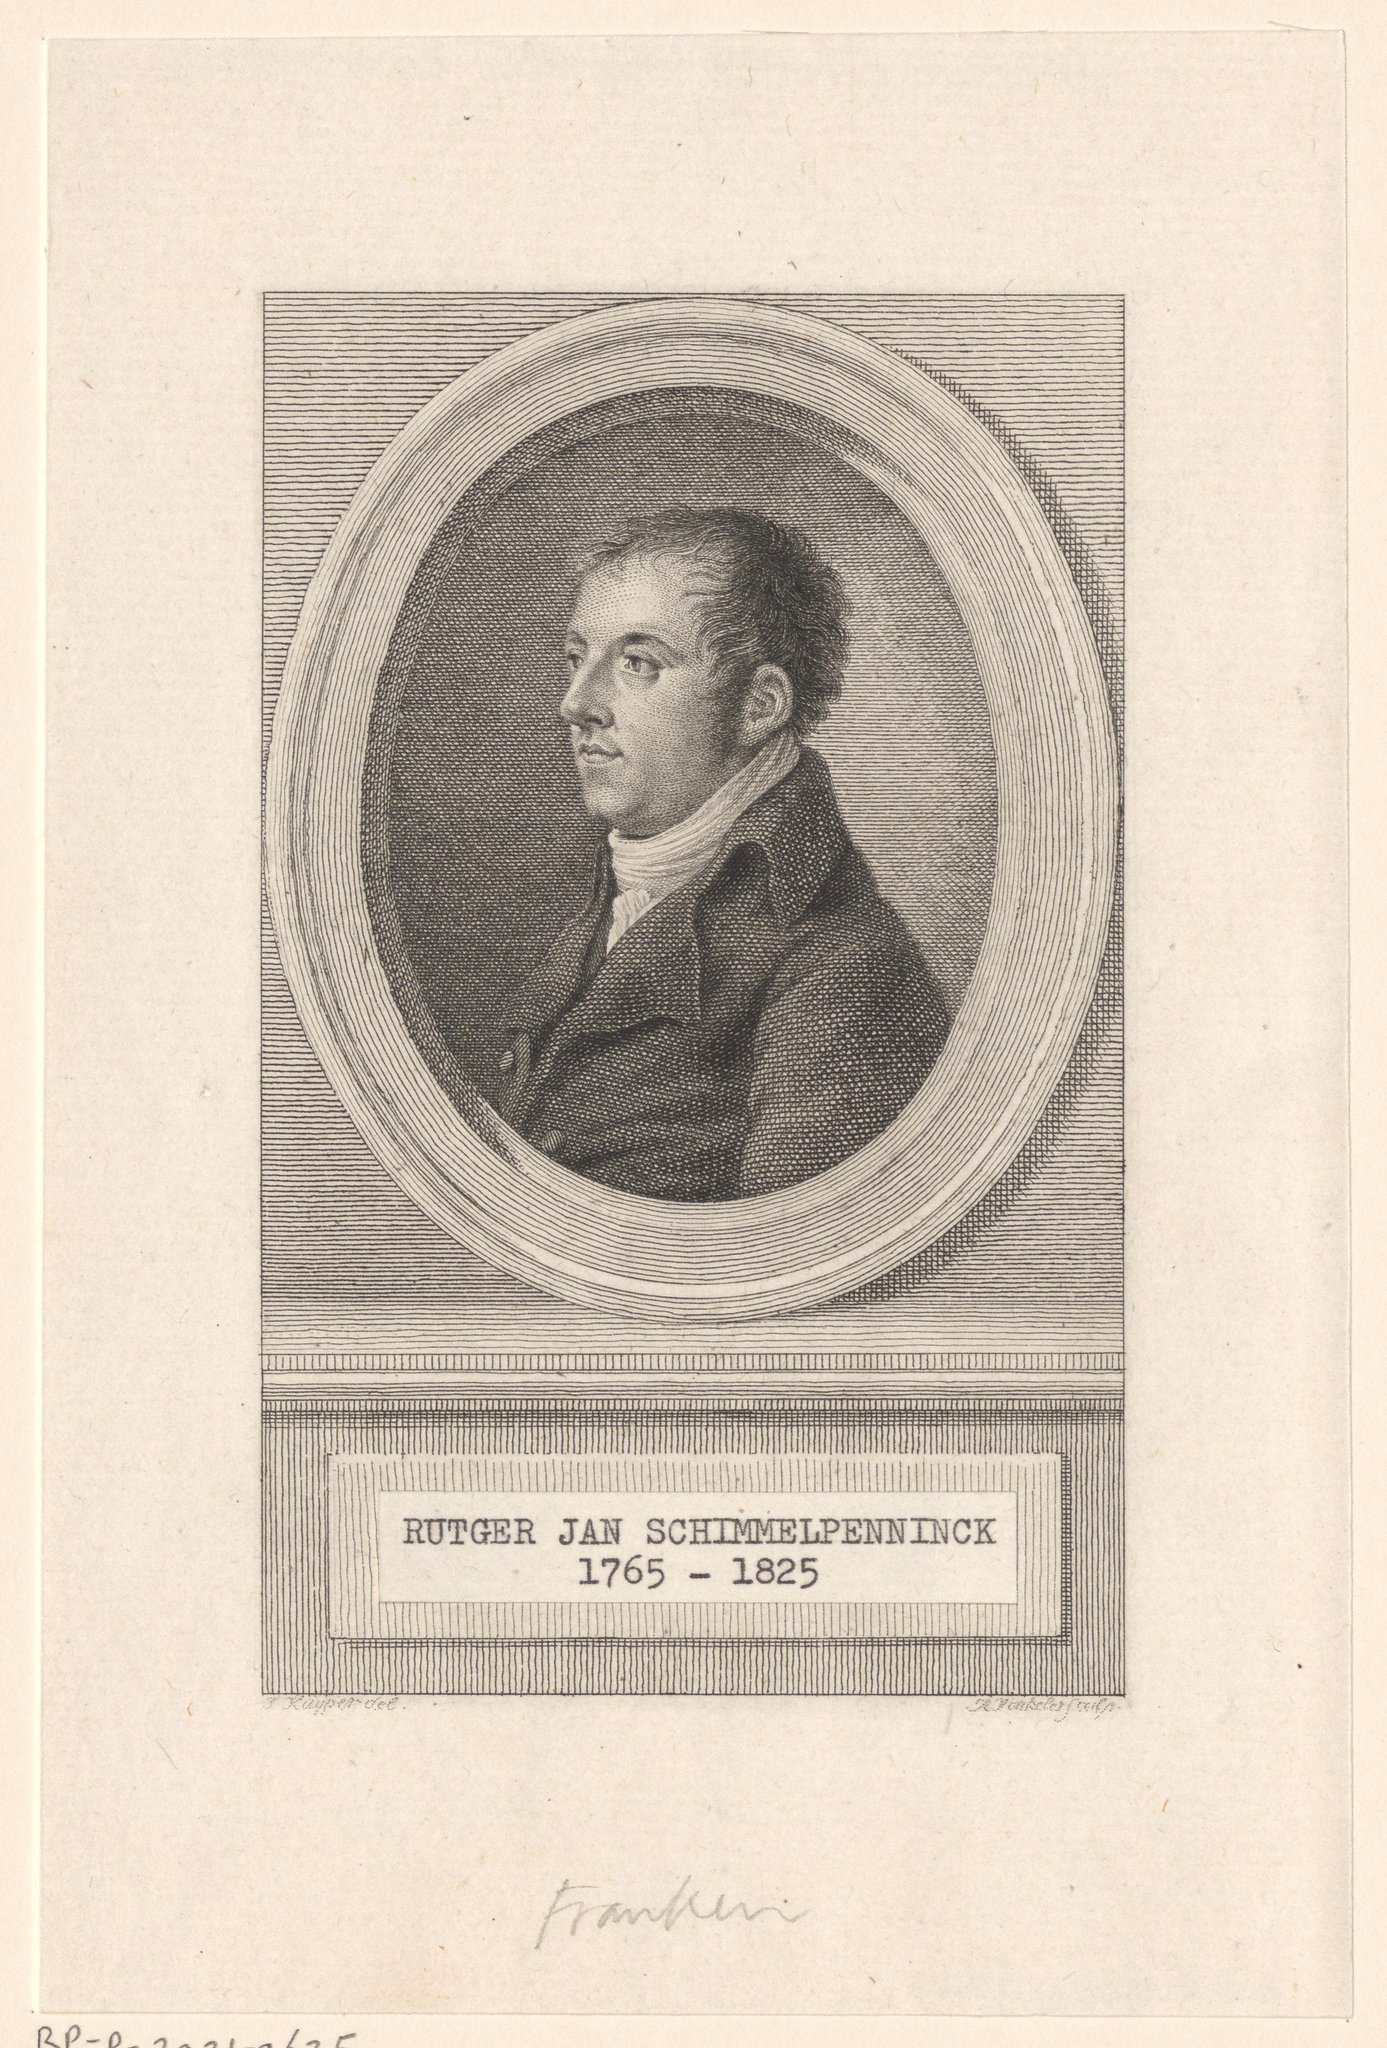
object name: print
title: Portret van Rutger Jan Schimmelpenninck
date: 1805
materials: paper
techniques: engraving, etching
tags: deventer, amsterdam, rutger jan schimmelpenninck (1761-1825), historical persons, politician, e.g. party leader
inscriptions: inscription: ‘In bruikleen van het/ Rijksprentenkabinet/ Nov. 1960’, collector's mark: Lugt 2228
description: Latere staat van prent gebruikt in: Wagenaar, Jan. Vaderlandsche historie, (...) ten vervolge van Wagenaars Vaderlandsche historie. 43 dln. Amsterdam: Johannes Allart, 1805, dl. 35.